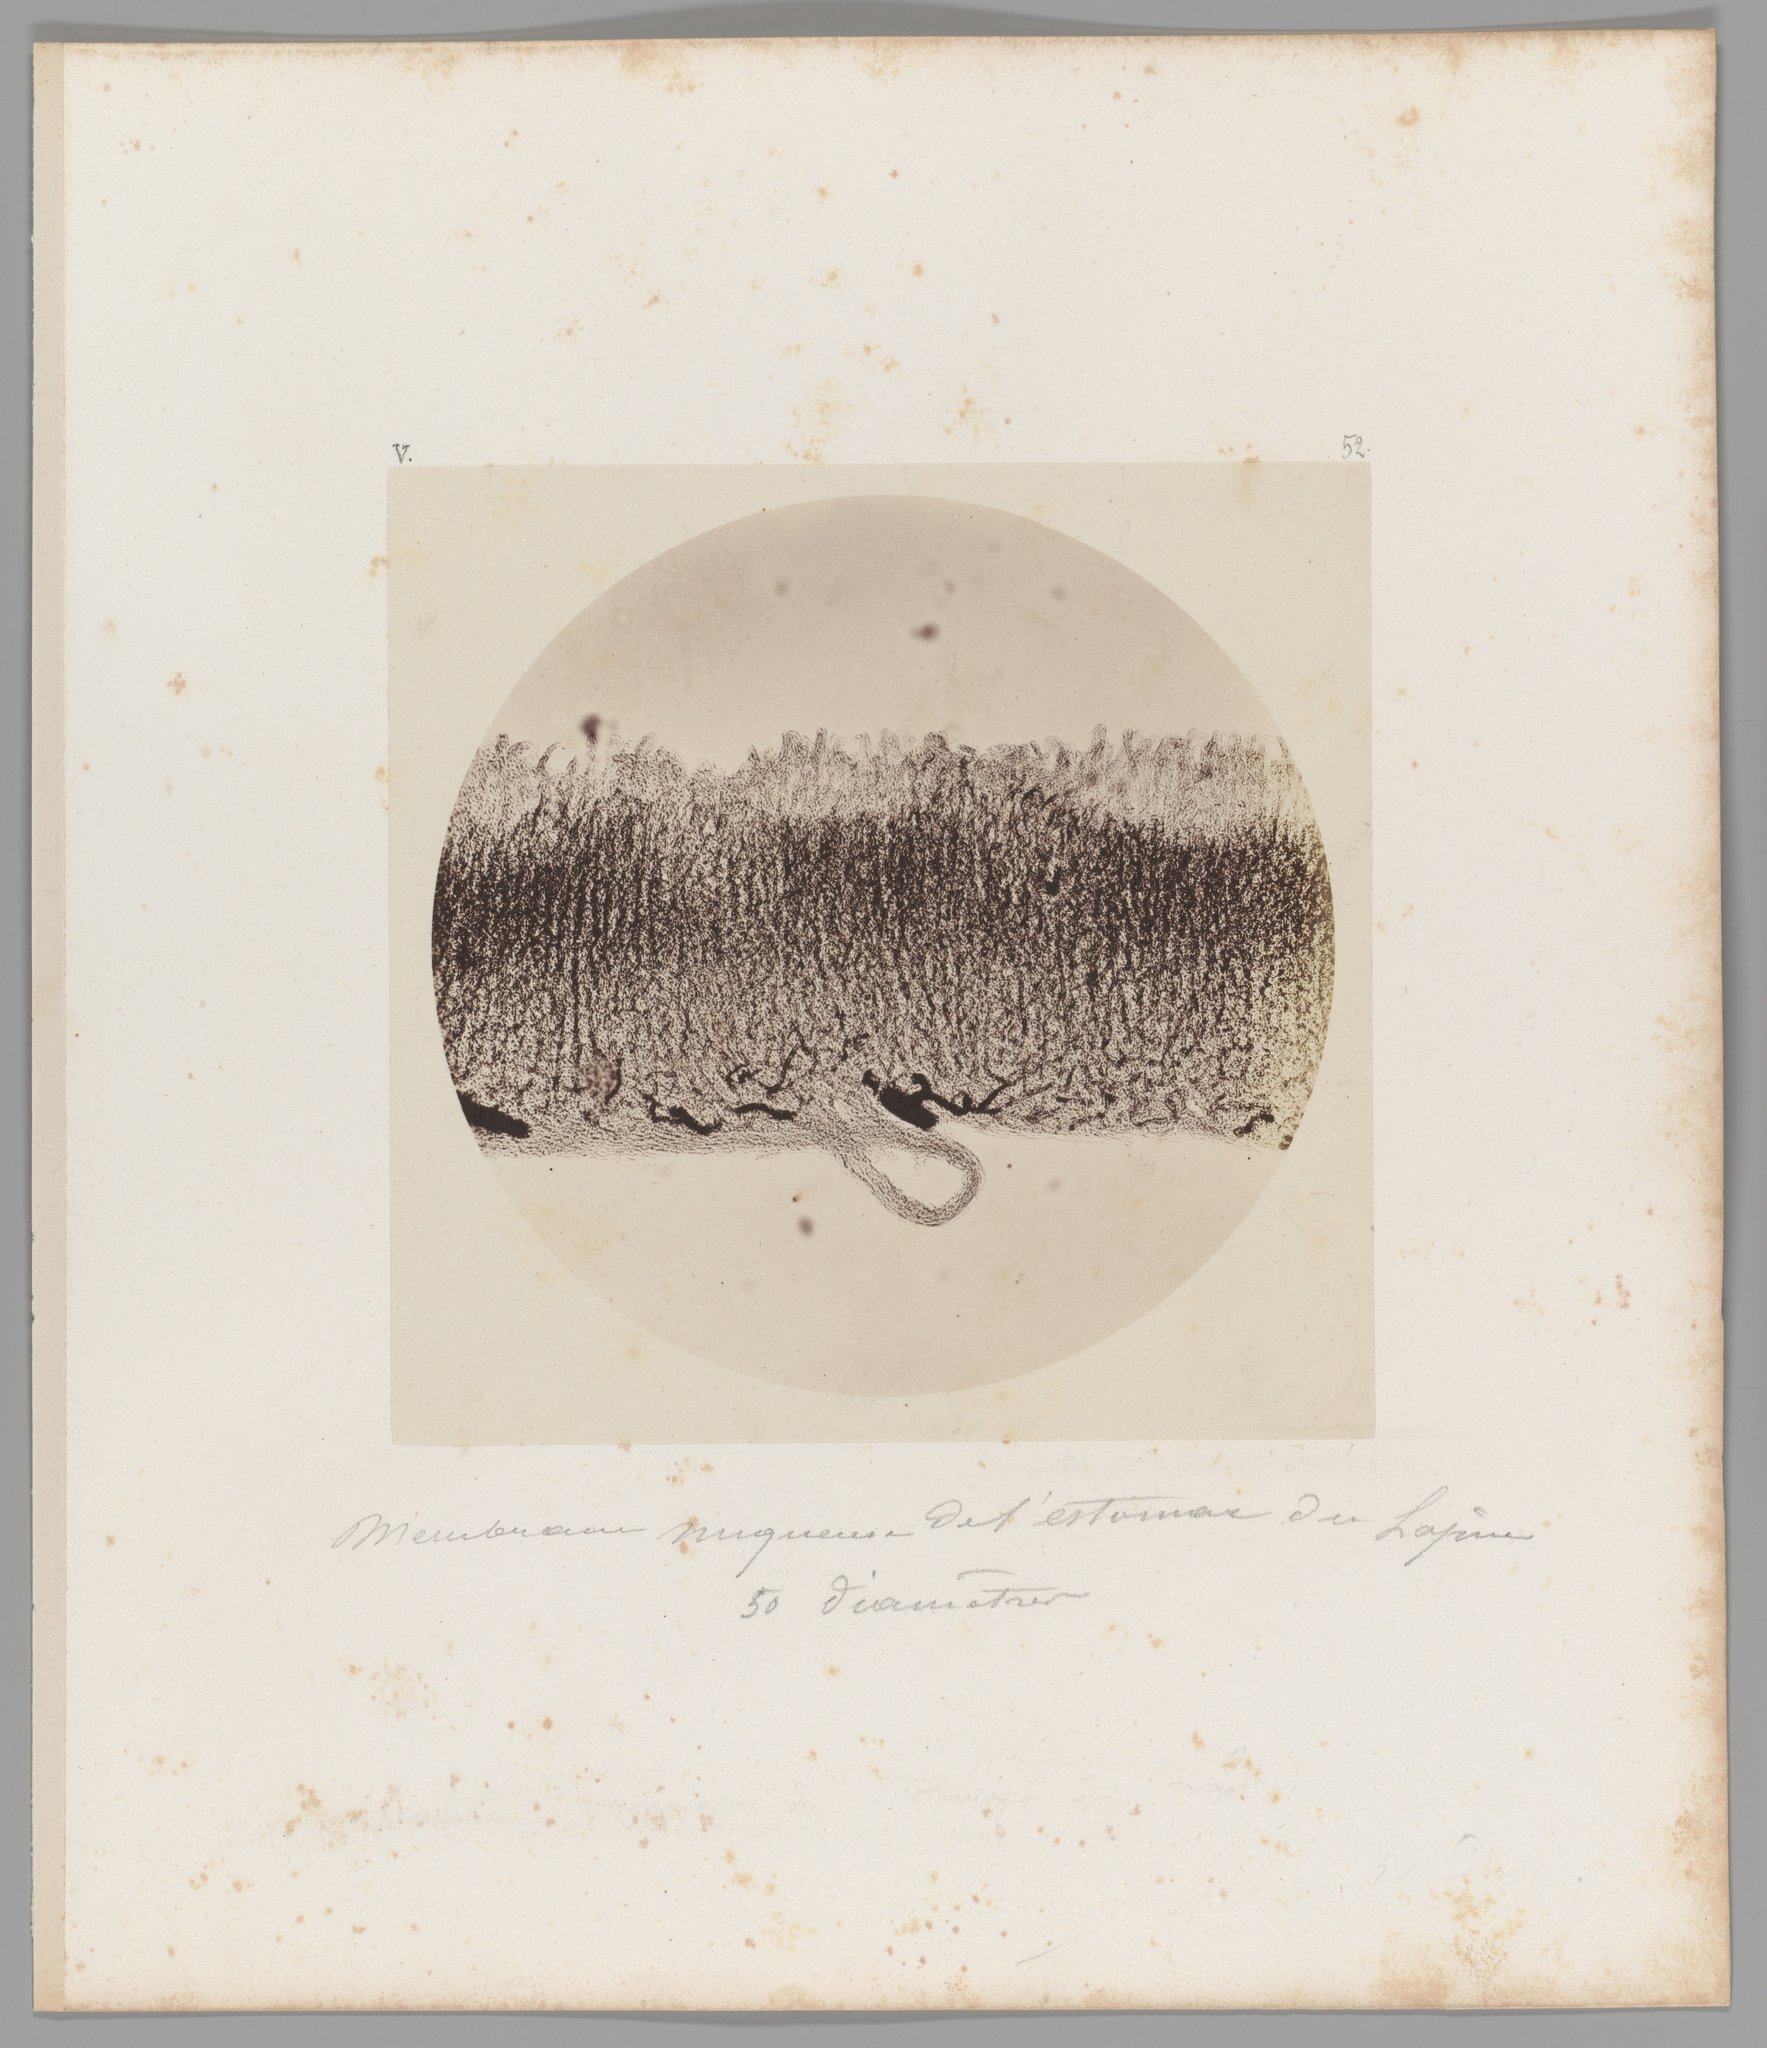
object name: photograph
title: [Untitled]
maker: auguste-adolphe bertsch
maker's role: artist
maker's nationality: french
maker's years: 1813-1871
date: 1853-1857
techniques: salted paper print